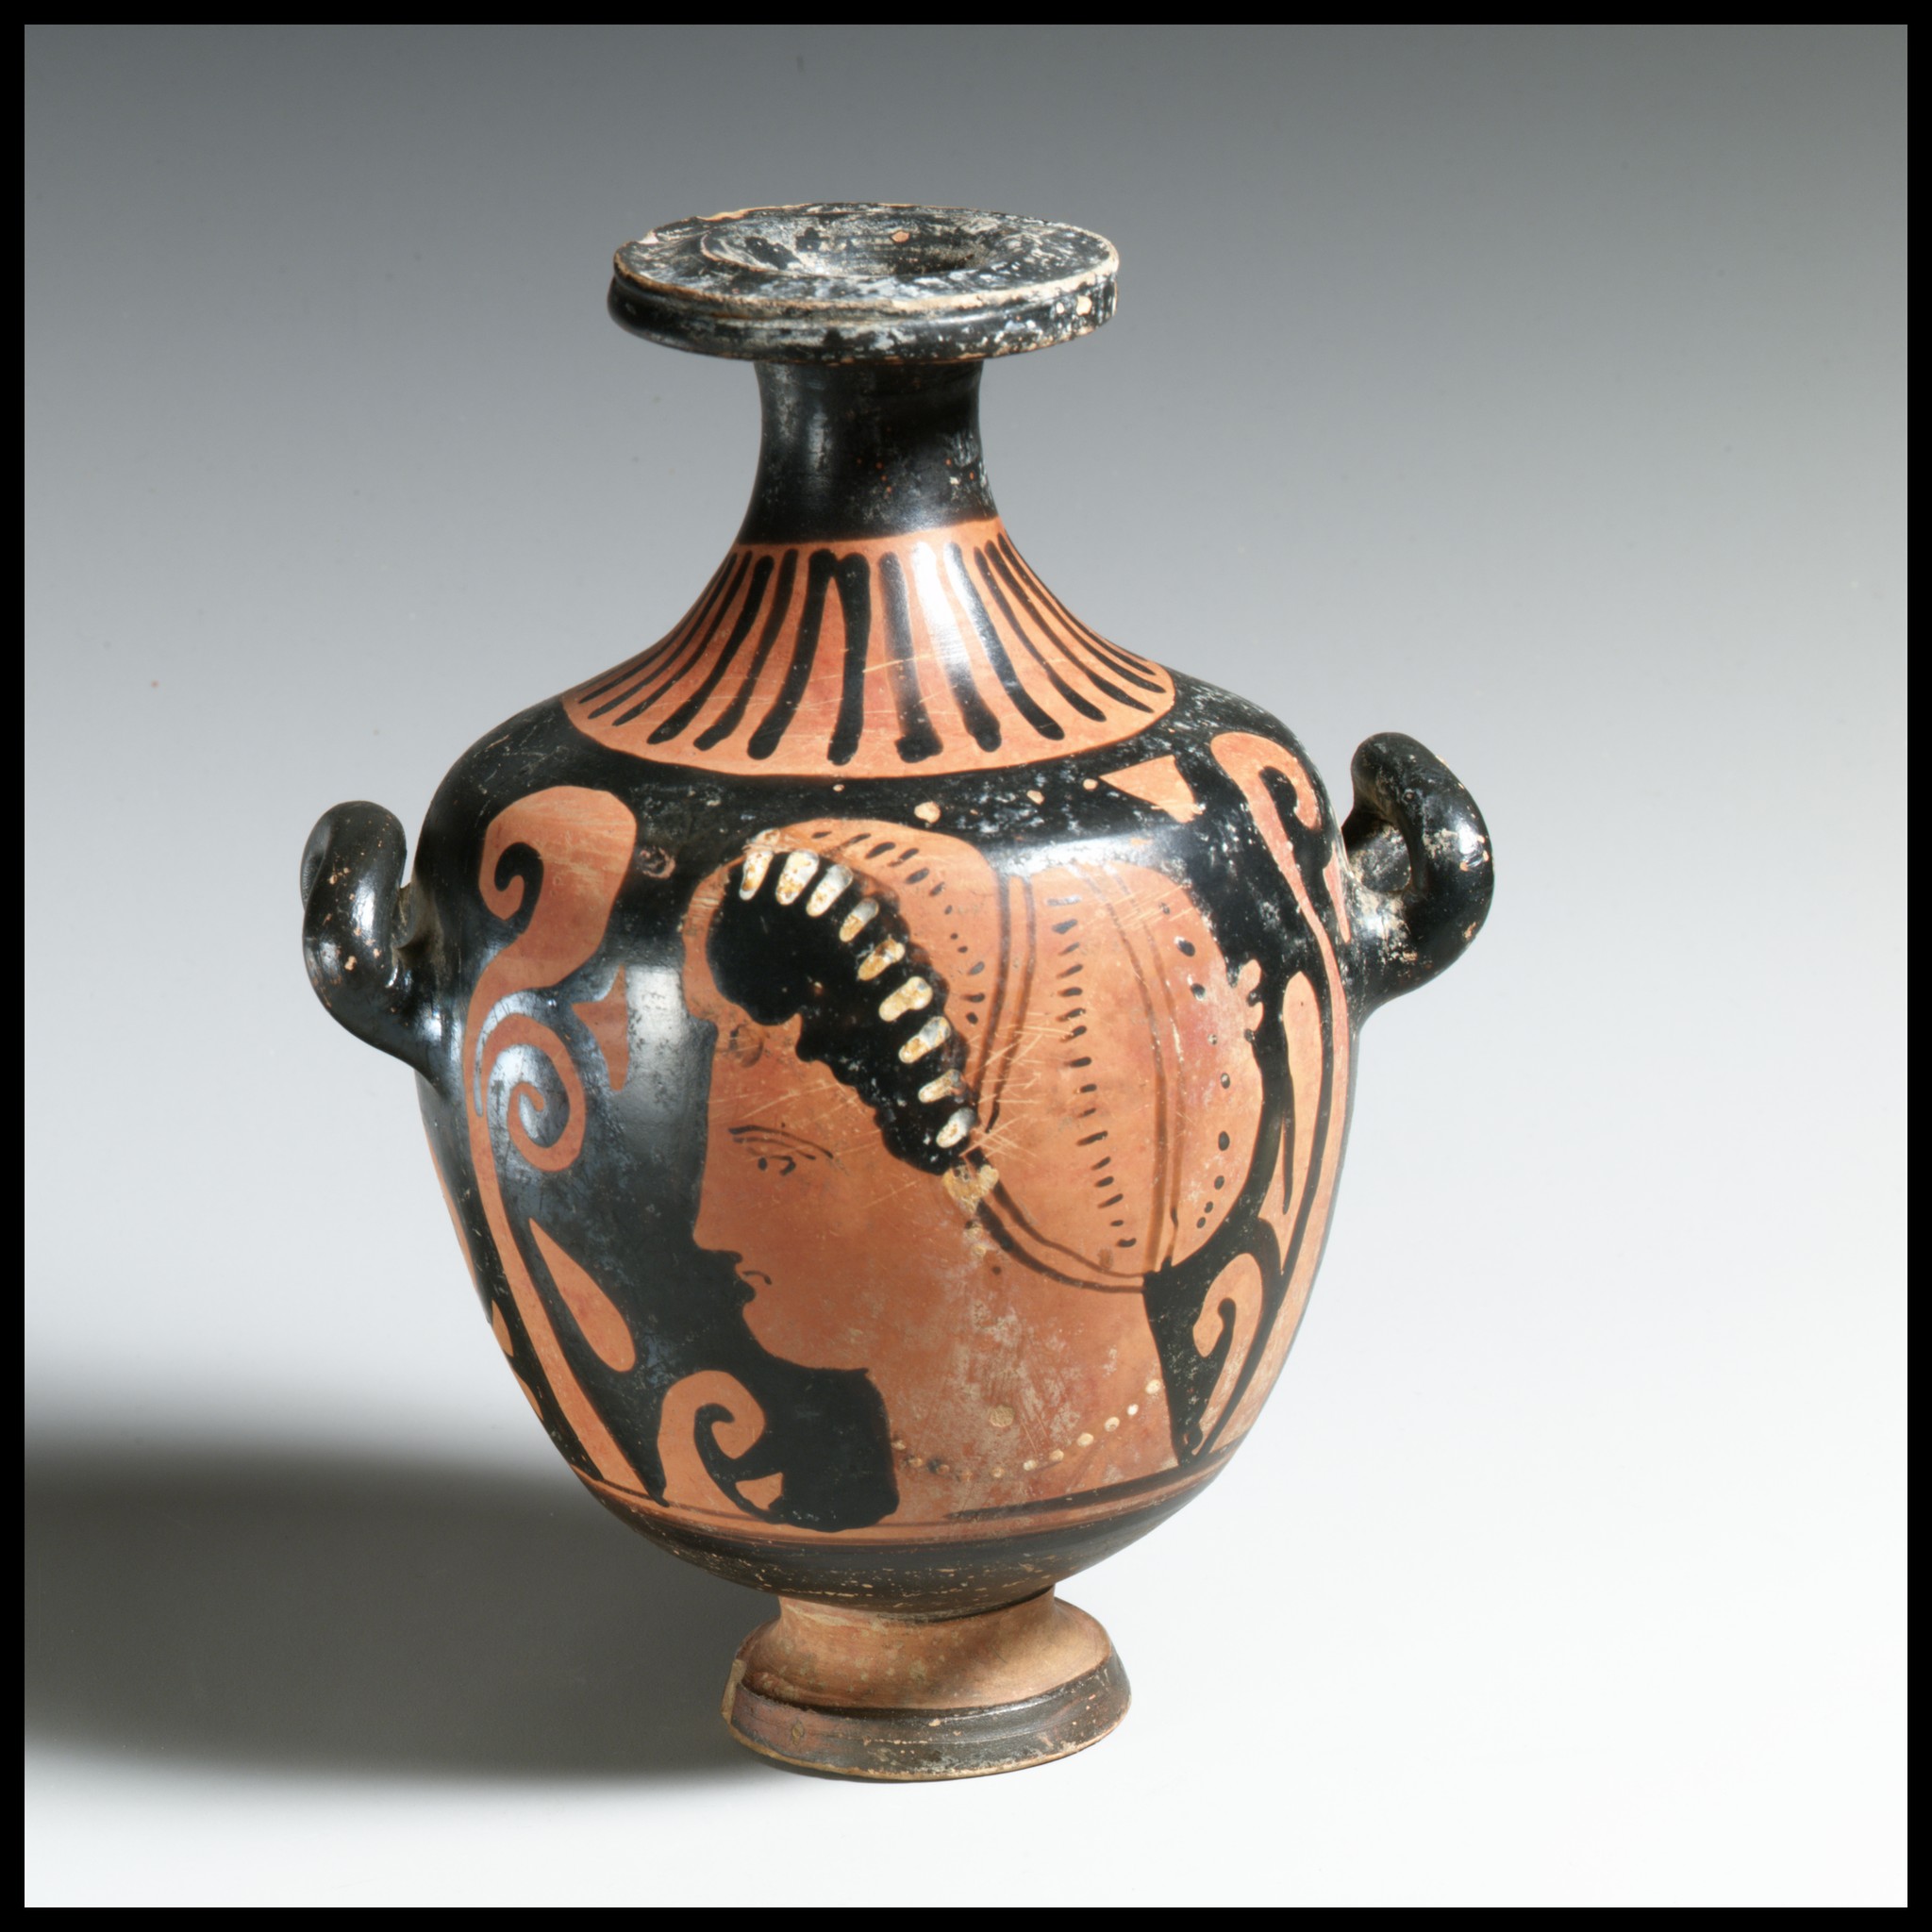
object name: hydria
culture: greek, south italian, apulian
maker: perth group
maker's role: artist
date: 350-320 BCE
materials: terracotta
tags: women